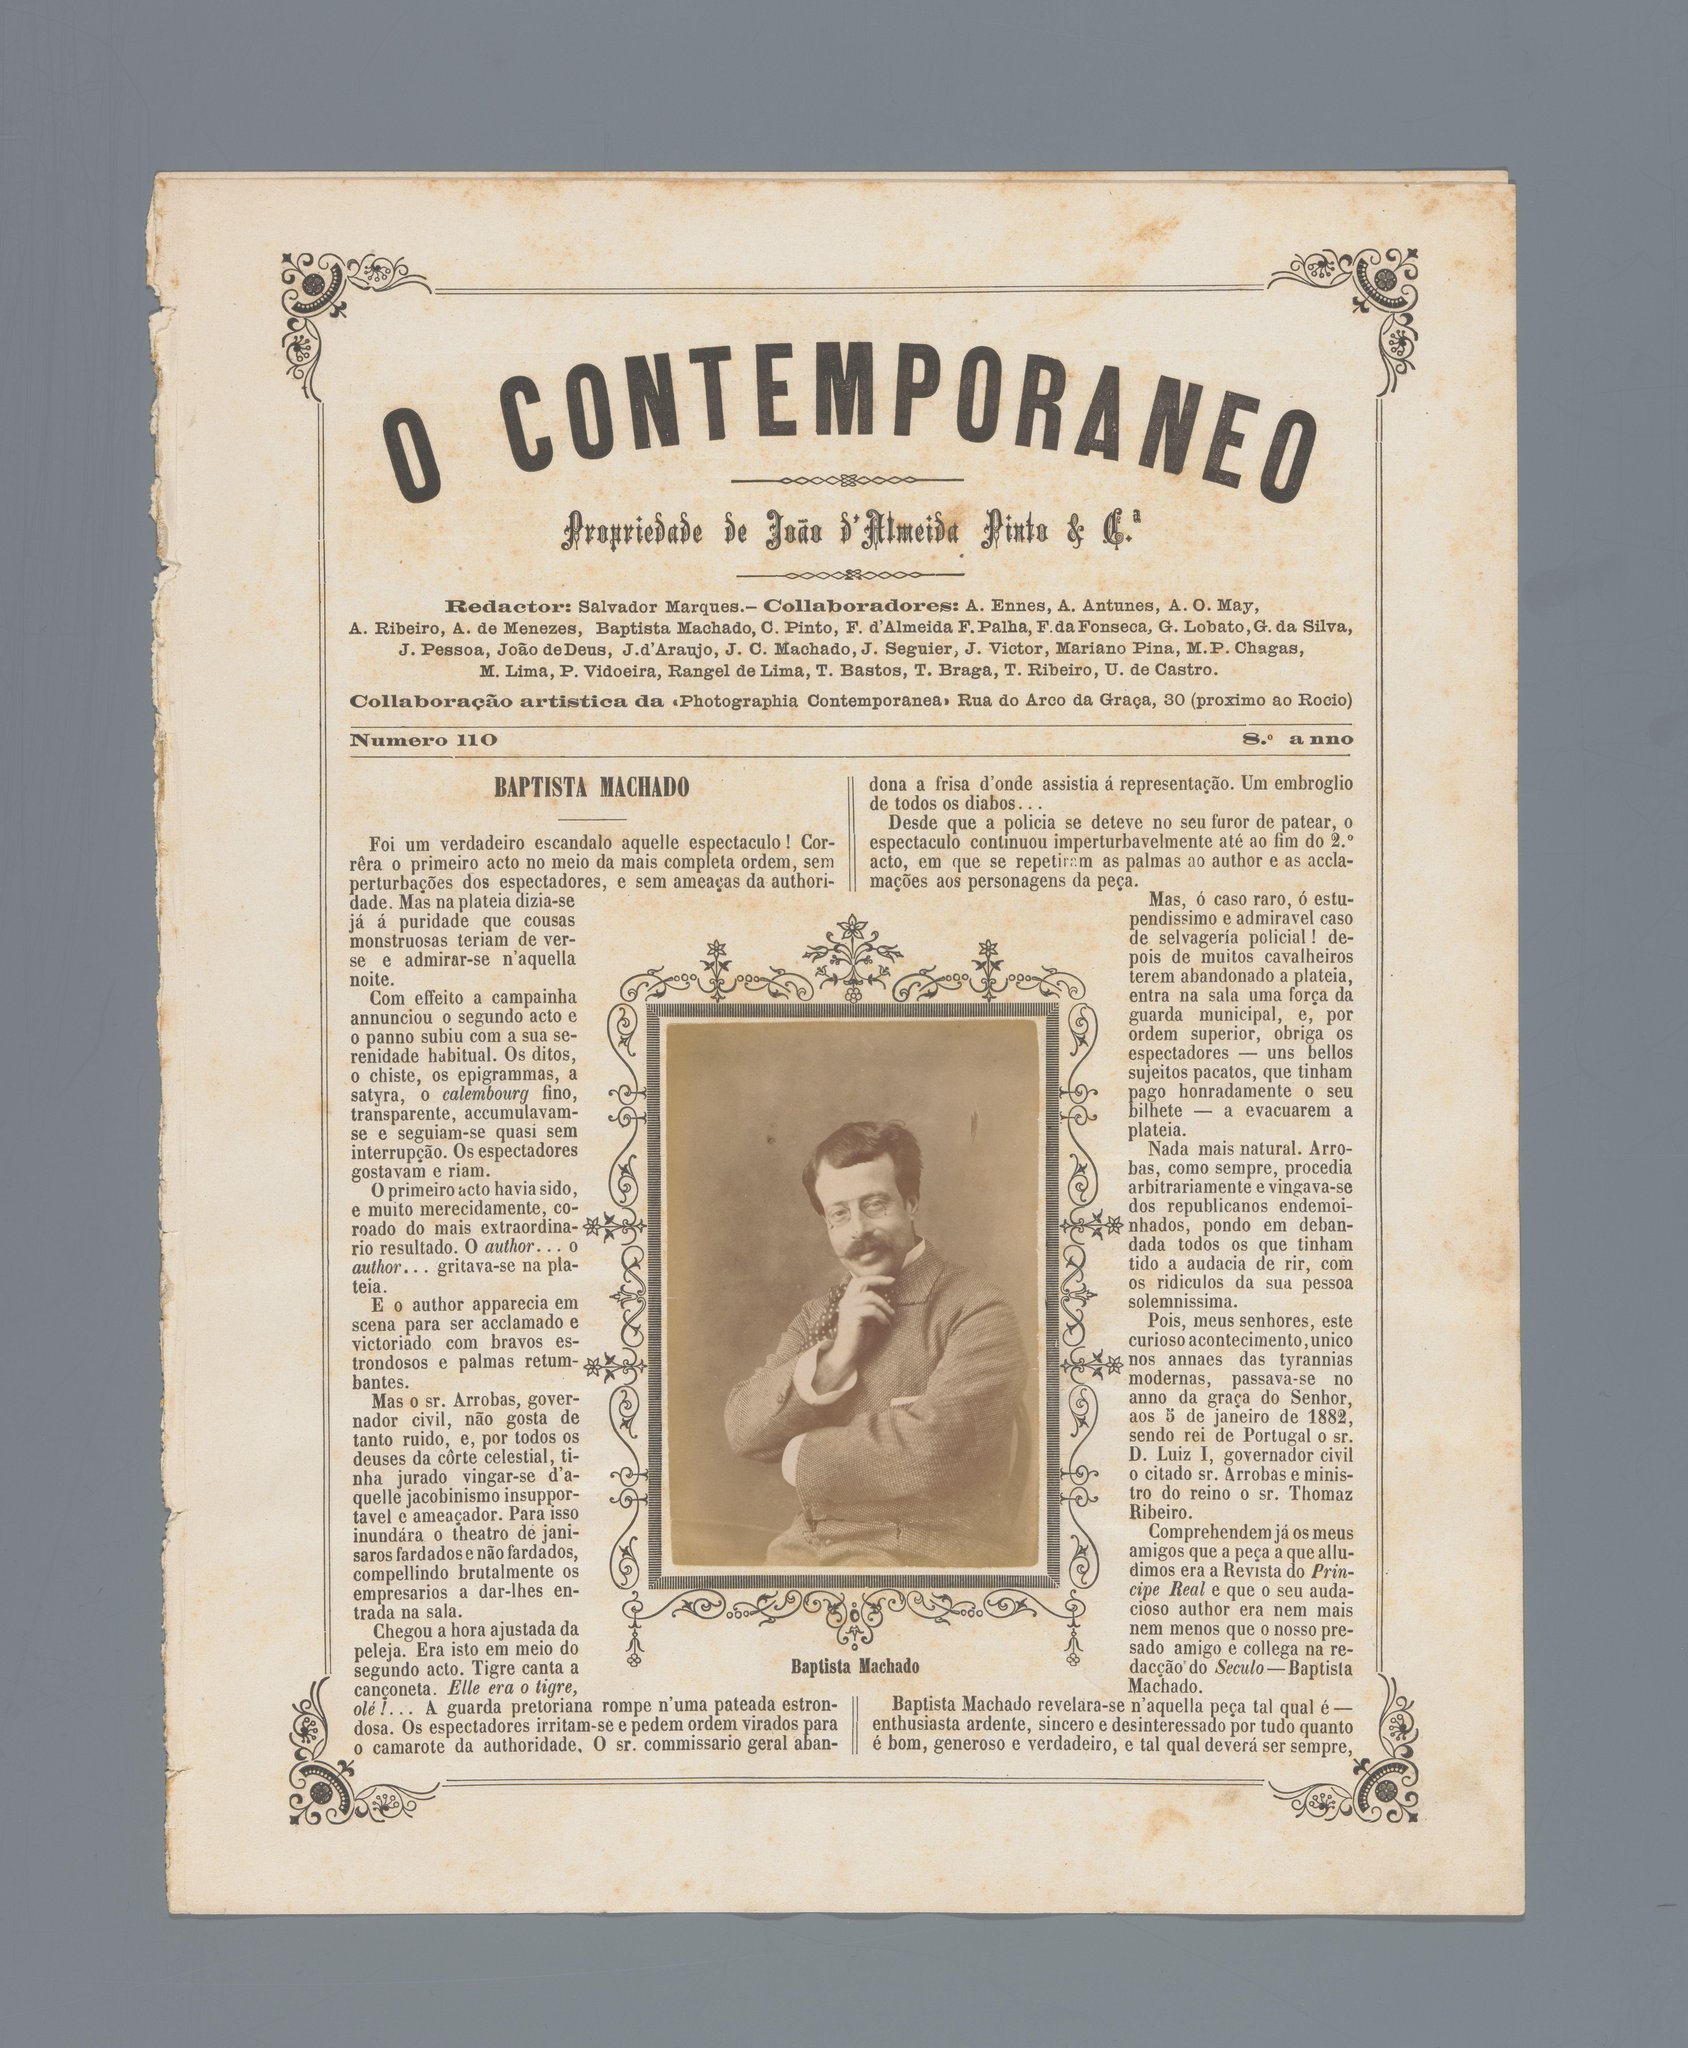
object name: photograph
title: O contemporaneo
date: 1877-1882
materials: paper, photographic support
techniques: albumen print, printing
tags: historical persons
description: Op de voorpagina bevindt zich een portret van Baptista Machado.